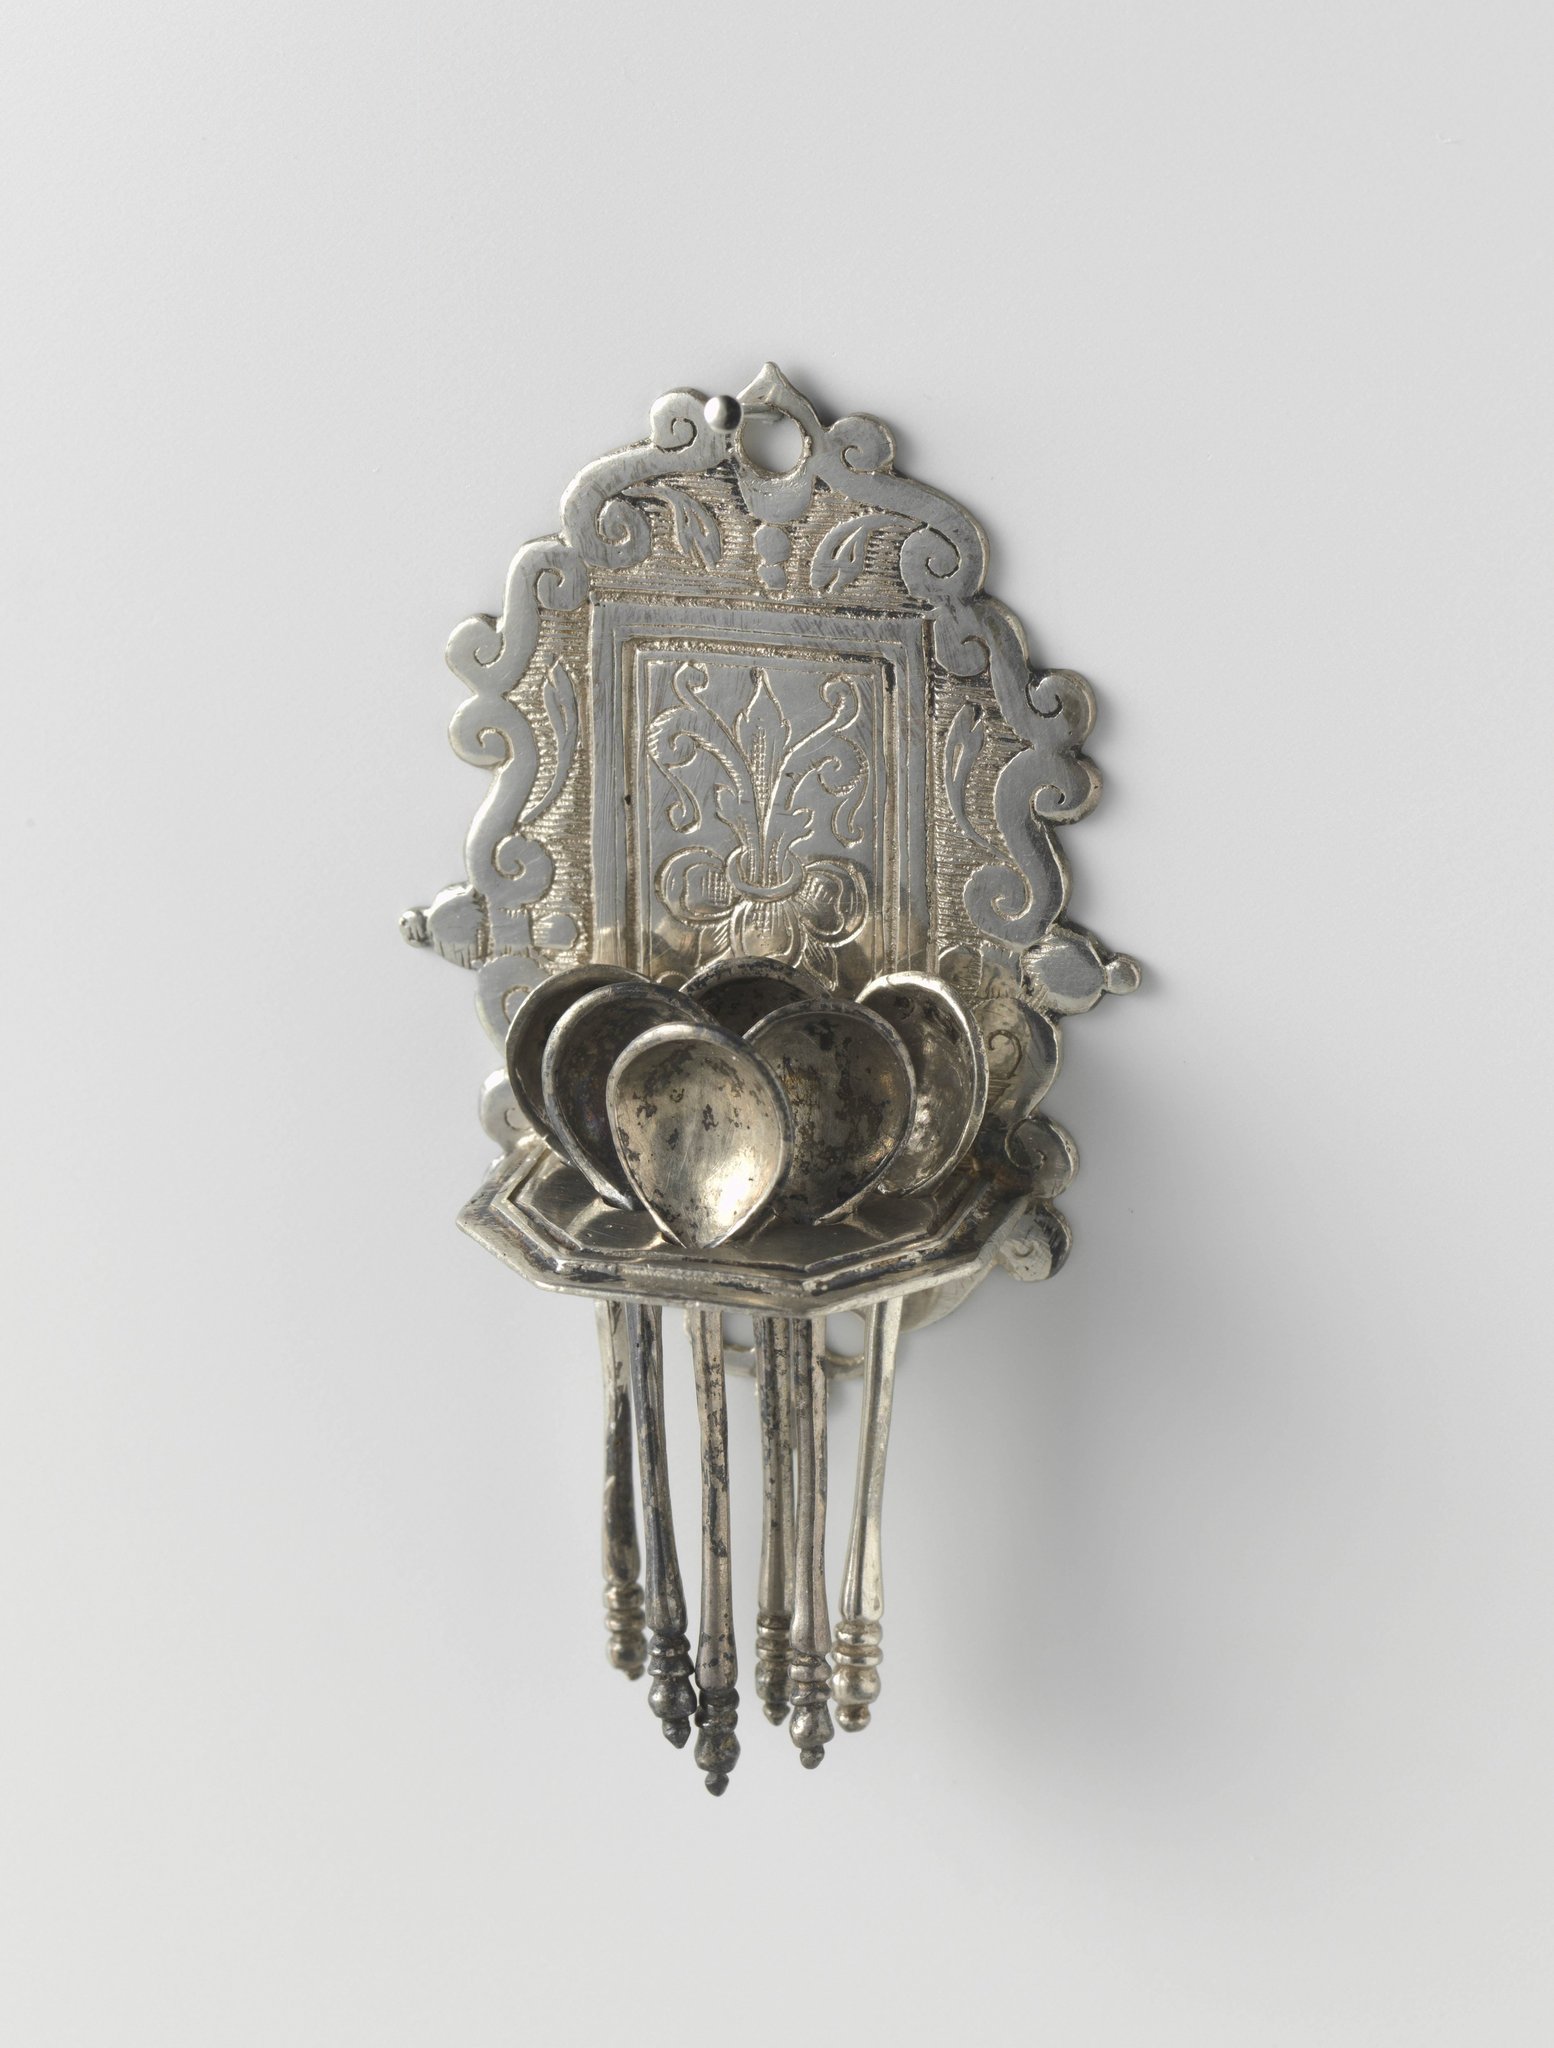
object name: miniature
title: Lepelrek met zes lepels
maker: Anonymous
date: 1600-1699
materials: silver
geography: amsterdam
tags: spoon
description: Lepelrek met zes lepels. In de plaat van het lepelrek is een ornament gegraveerd. De lepels zijn rond met een steel die aan het uiteinde is geprofileerd en uitloopt in een knop. Het lepelrek is niet gemerkt. Sommige lepels zijn gemerkt met een zwijnskop ( vgl. inventarisnr. BK-NM-11177-236).